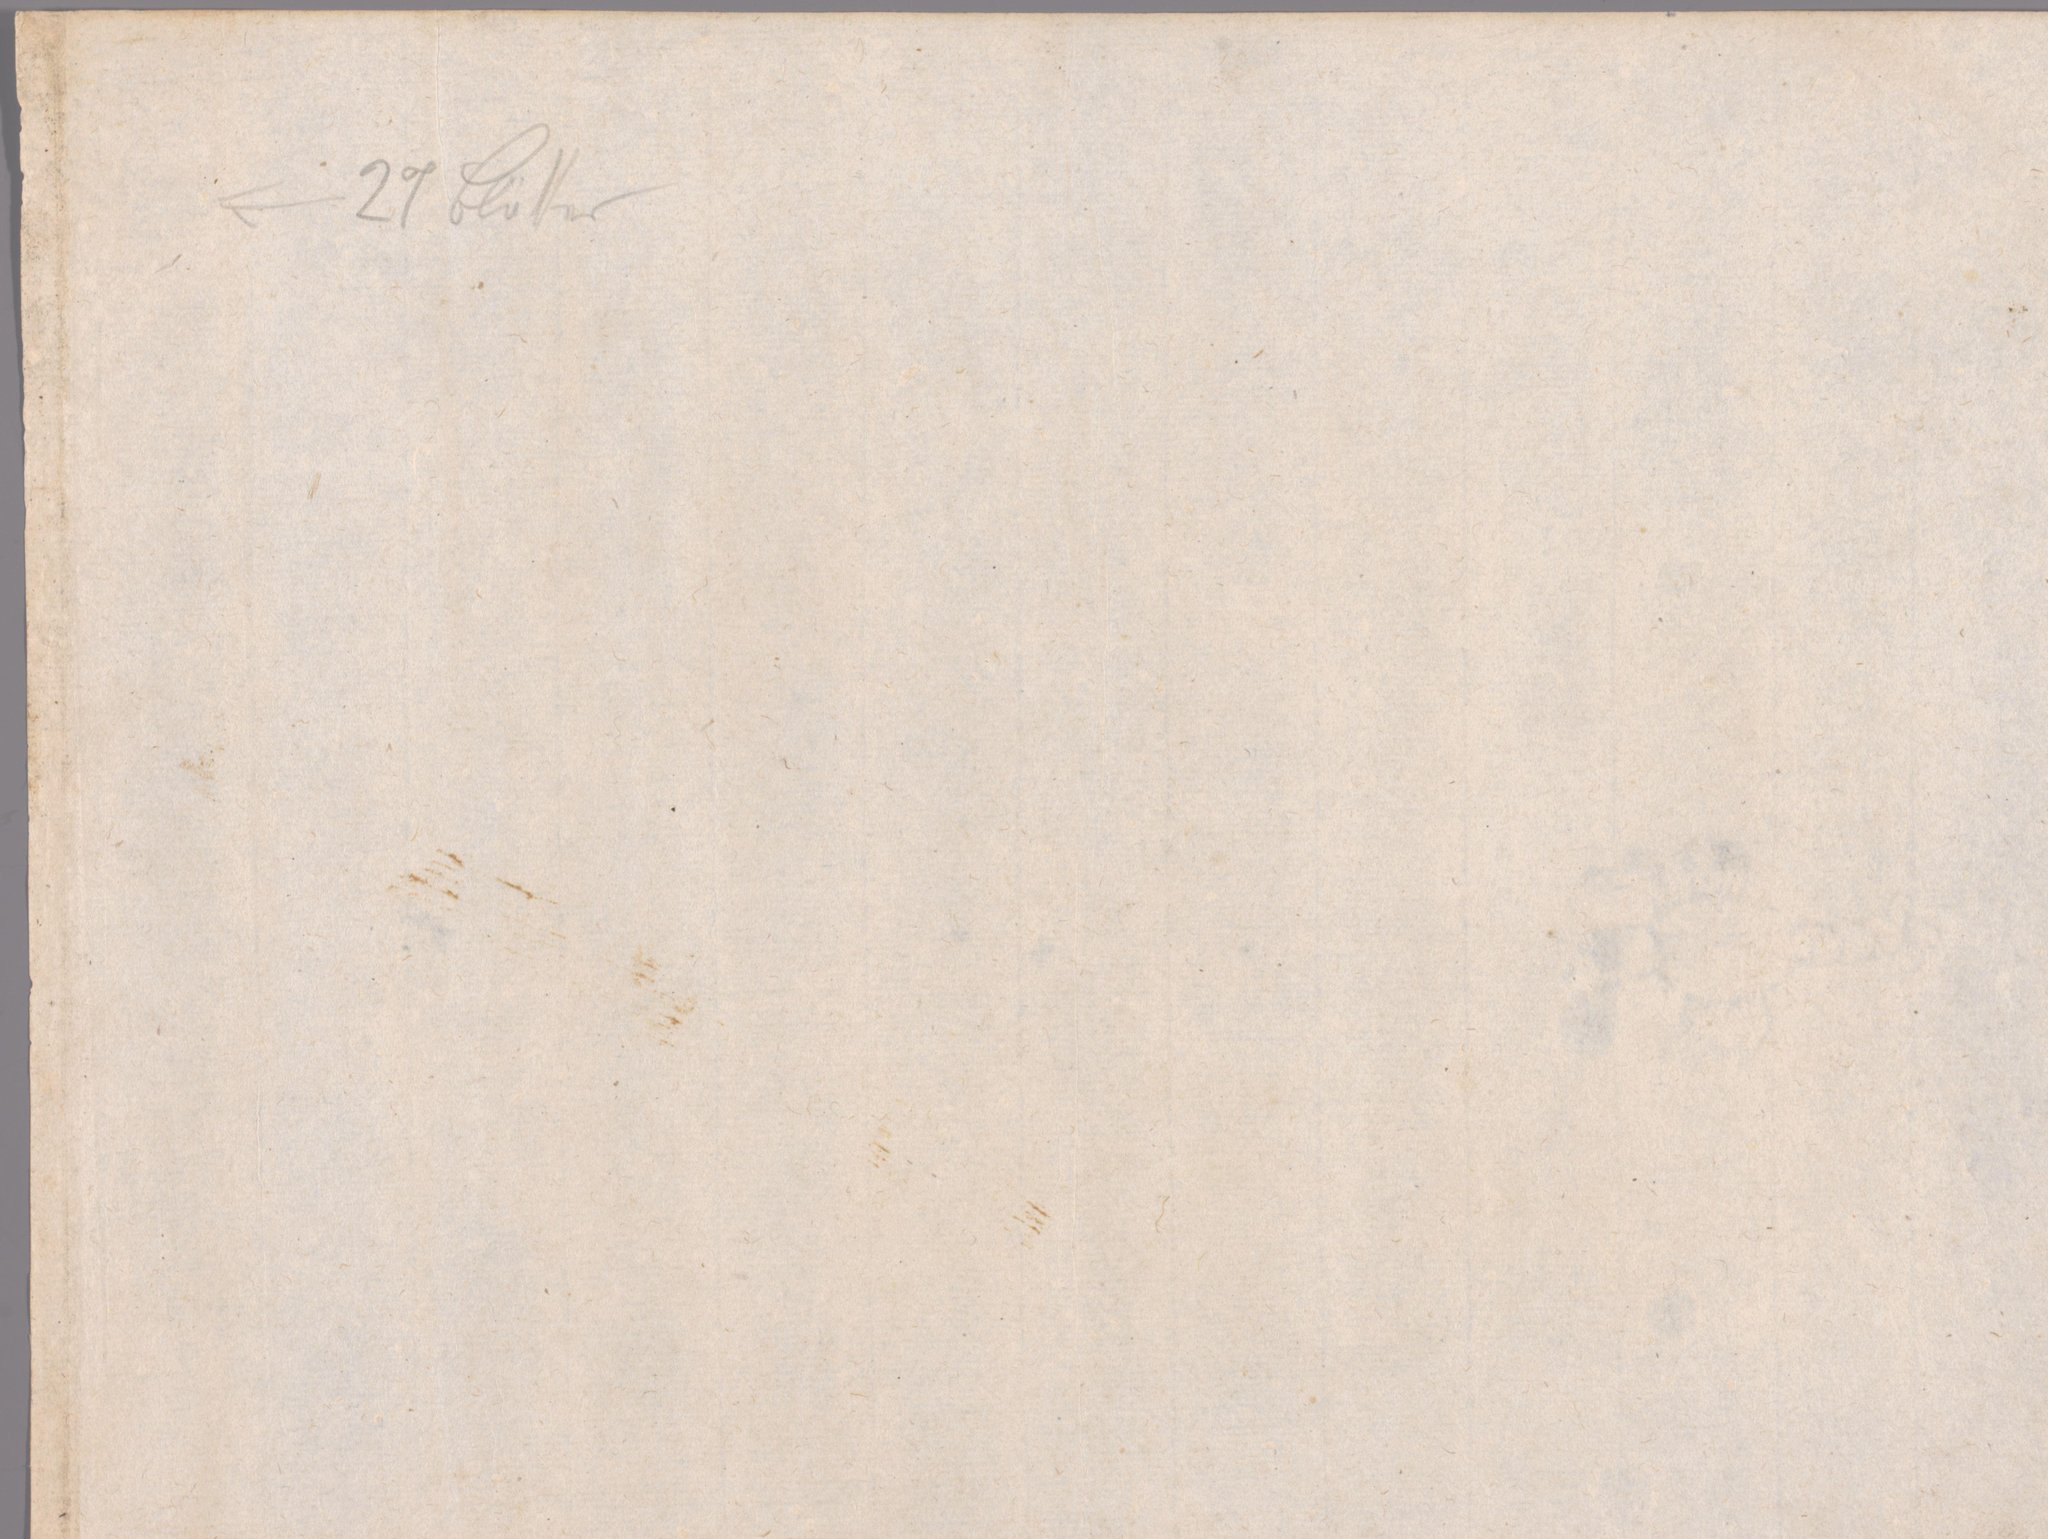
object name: endleaf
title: Schutblad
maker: Anonymous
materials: paper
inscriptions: collector's mark: Lugt 2228, watermark:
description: Deel van een ontmanteld album waarvan RP-P-2013-1-54-1 t/m -37, RP-P-2013-1-55-1 en -2 en RP-P-2013-1-63 t/m 67 deel waren.